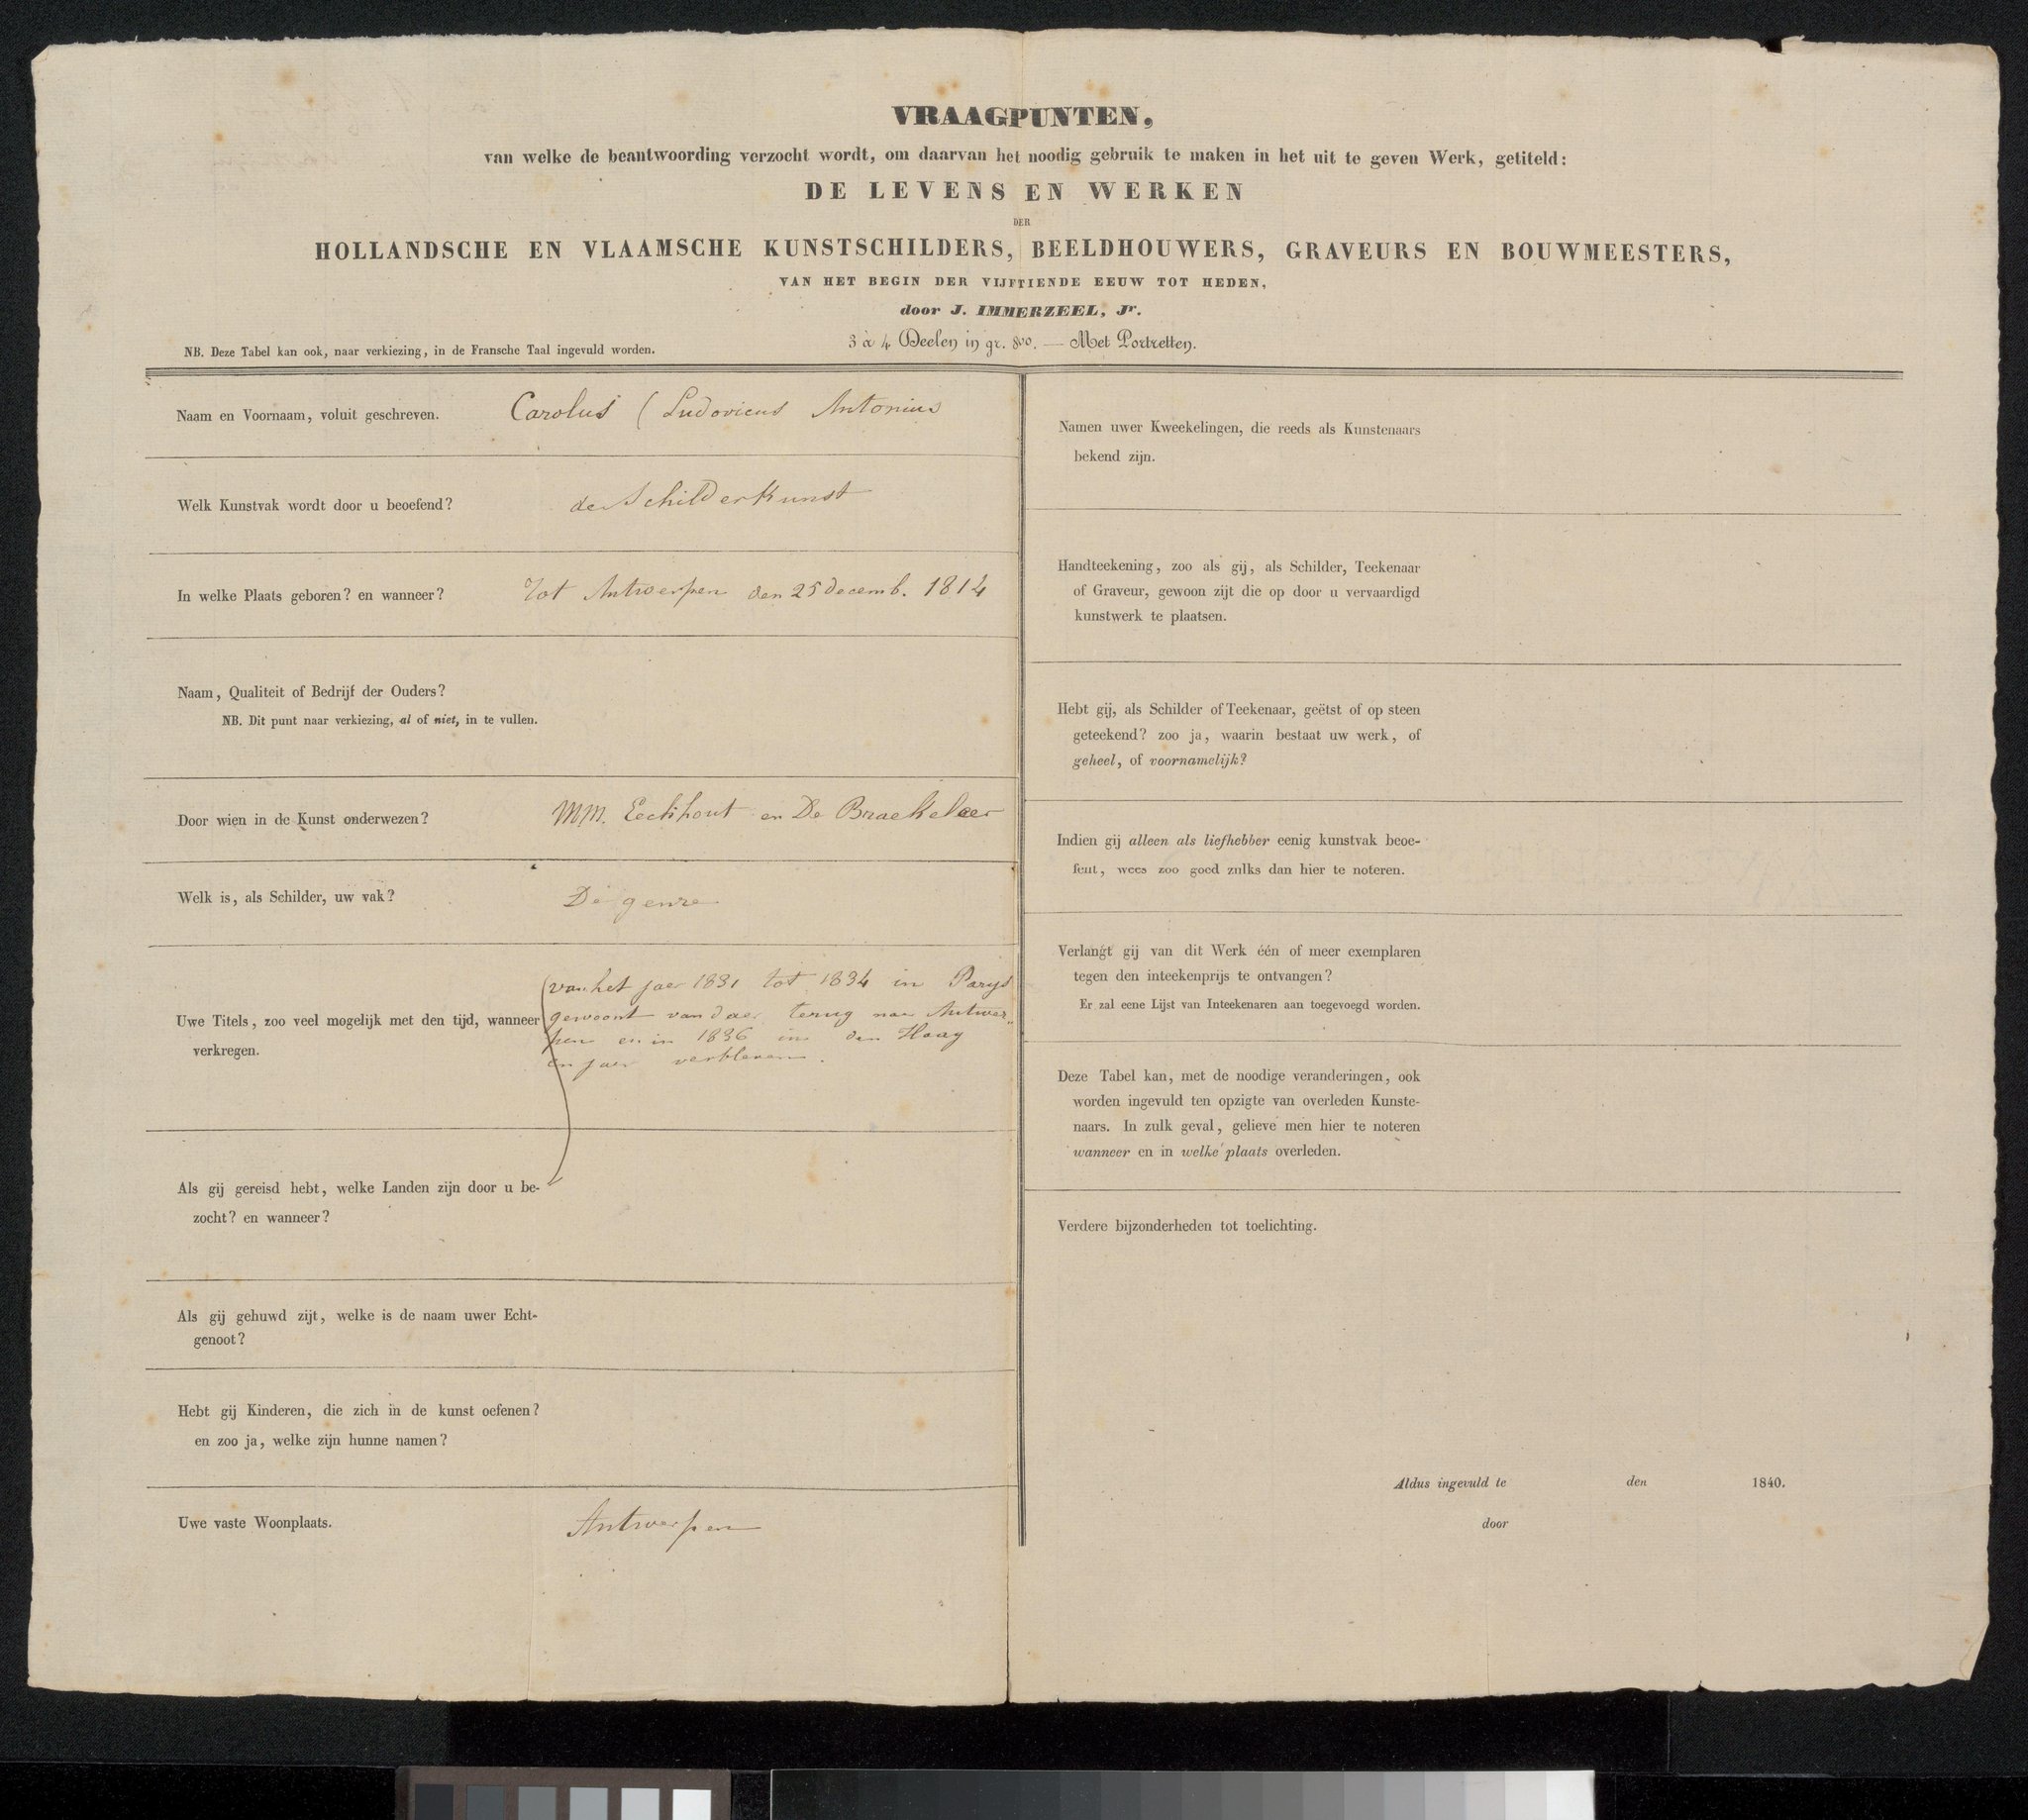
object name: manuscript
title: Enquêteformulier ingevuld door Louis Antione Carolus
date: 1840-1841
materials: ink, paper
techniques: pen, printing, writing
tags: brussels, print maker, louis antoine carolus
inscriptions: inscription: ‘Vraagpunten,/ van welke de beantwoording verzocht wordt, om daarvan het noodig gebruik te maken in het uit te geven Werk, getiteld: De levens en werken/ der Hollandsche en Vlaamsche kunstschilders, beeldhouwers,/ graveurs en bouwmeesters, van het begin der vijftiende eeuw tot heden/ door J. Immerzeel, Jr.’, watermark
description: Opgenomen in: Immerzeel, J. Jr., De levens en werken der Hollandsche en Vlaamsche kunstschilders, beeldhouwers, graveurs en bouwmeesters, van het begin der vijftiende eeuw tot heden, Amsterdam: J.C. van Kesteren, 1842-1843.